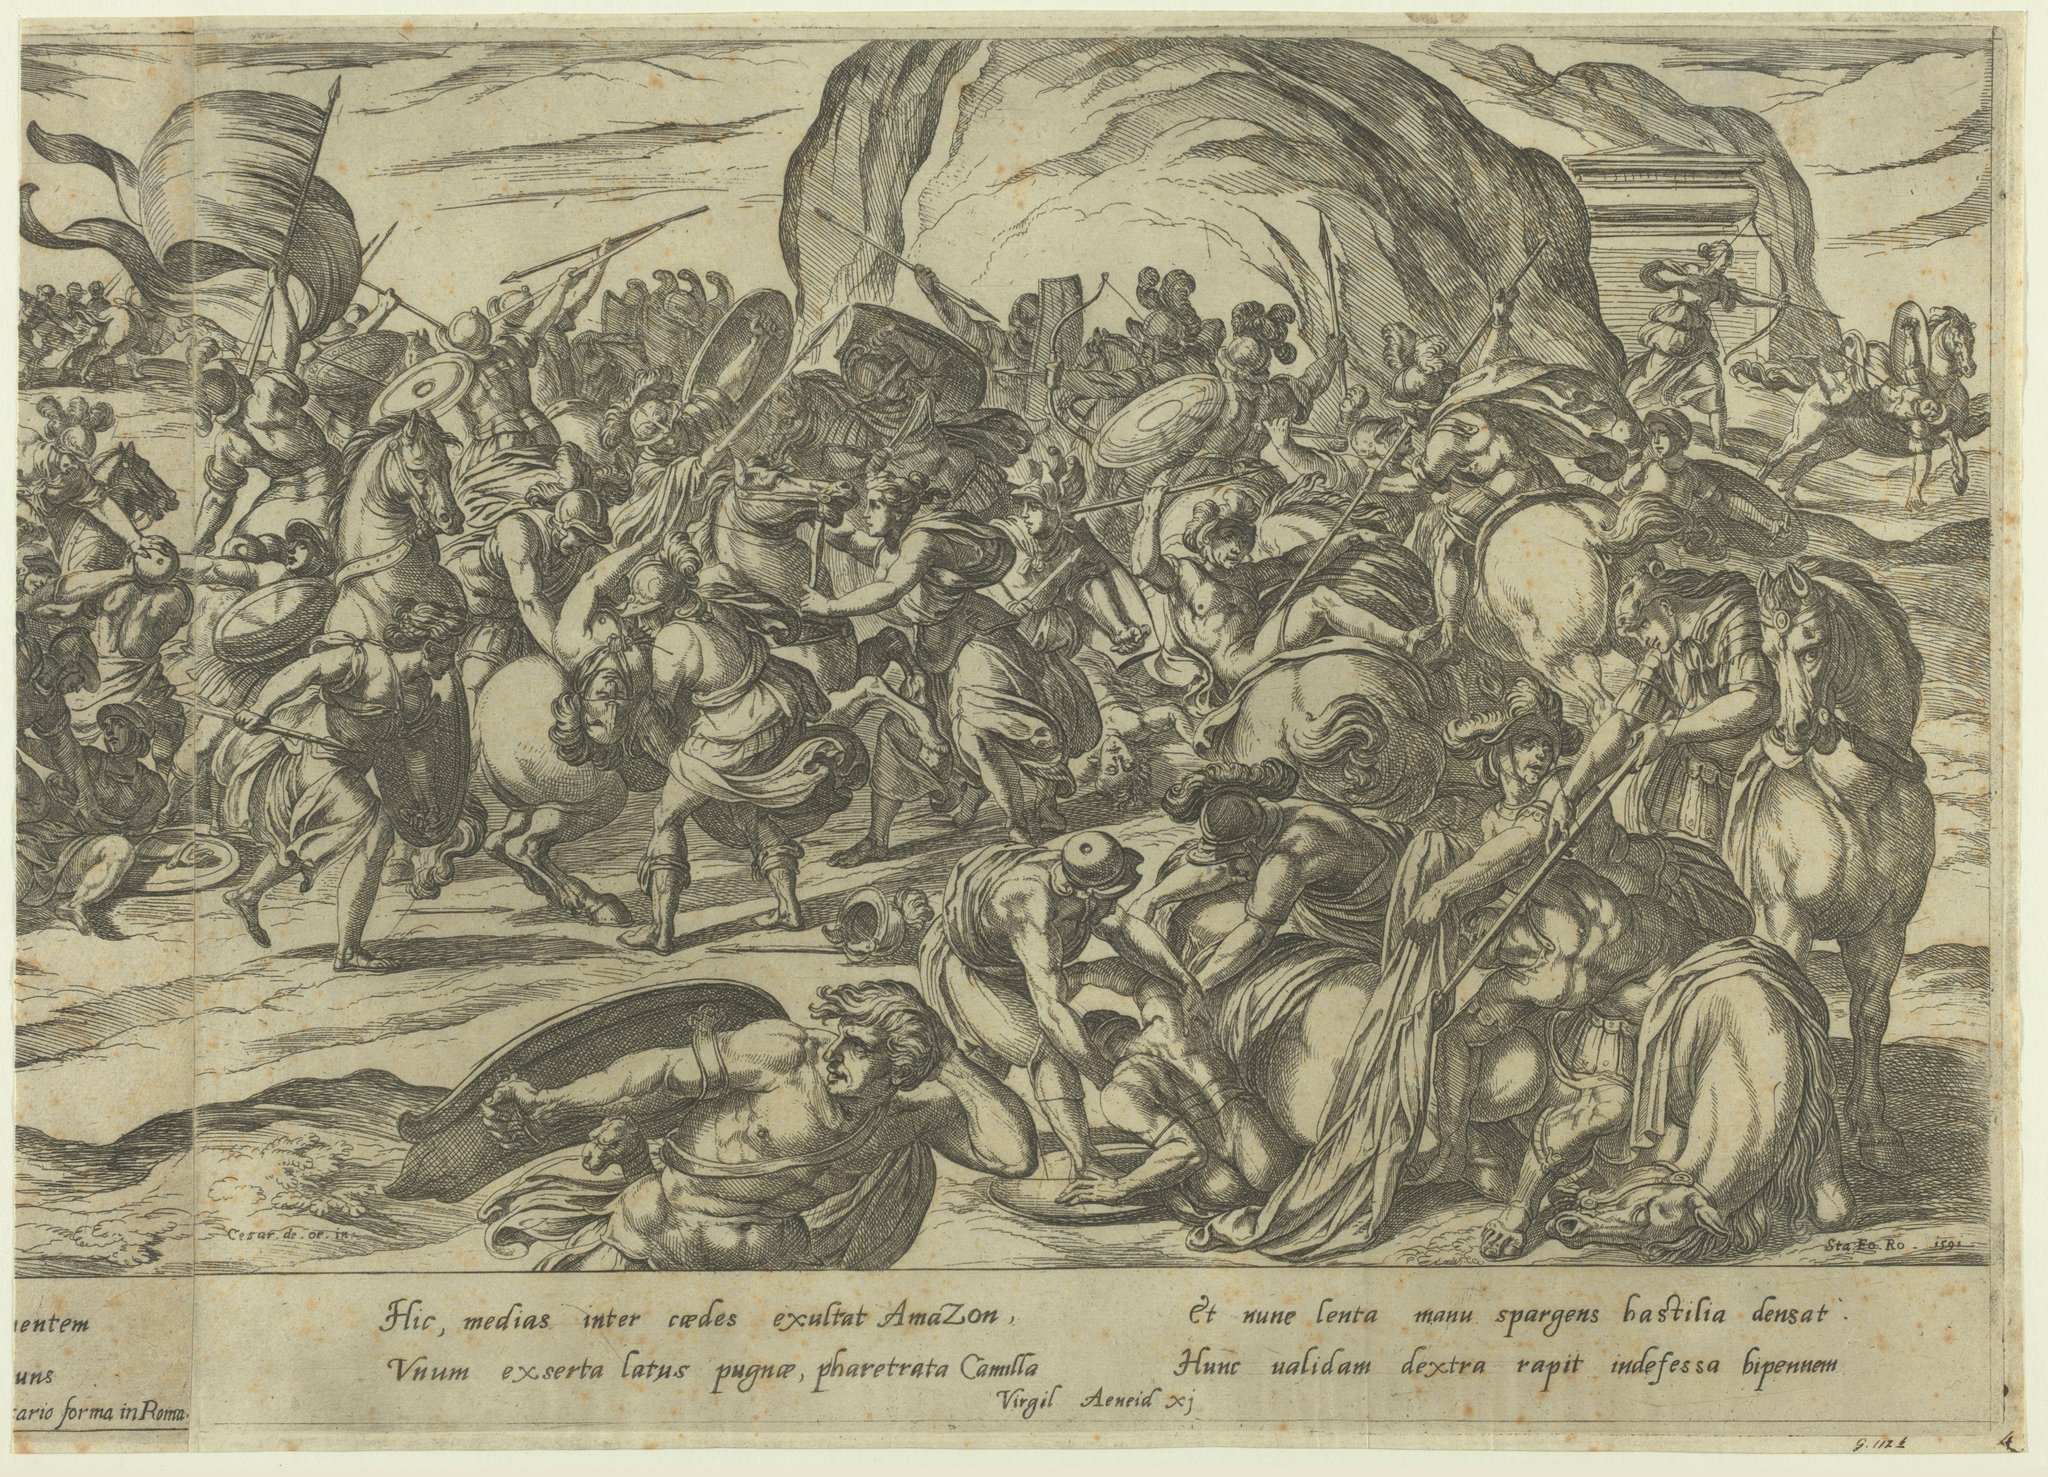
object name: print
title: De dood van Camillus in de strijd tussen Grieken en Romeinen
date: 1591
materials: paper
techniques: etching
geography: italy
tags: (story of) camilla - death, battle, the soldier; the soldier's life, warfare; military affairs (+ land forces)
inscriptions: collector's mark: ‘Hinloopen’, number: ‘4’, collector's mark: Lugt 11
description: De dood van Camillus in een strijdgewoel van Griekse en Romeinse soldaten te paard. Vers in het Latijn in ondermarge.